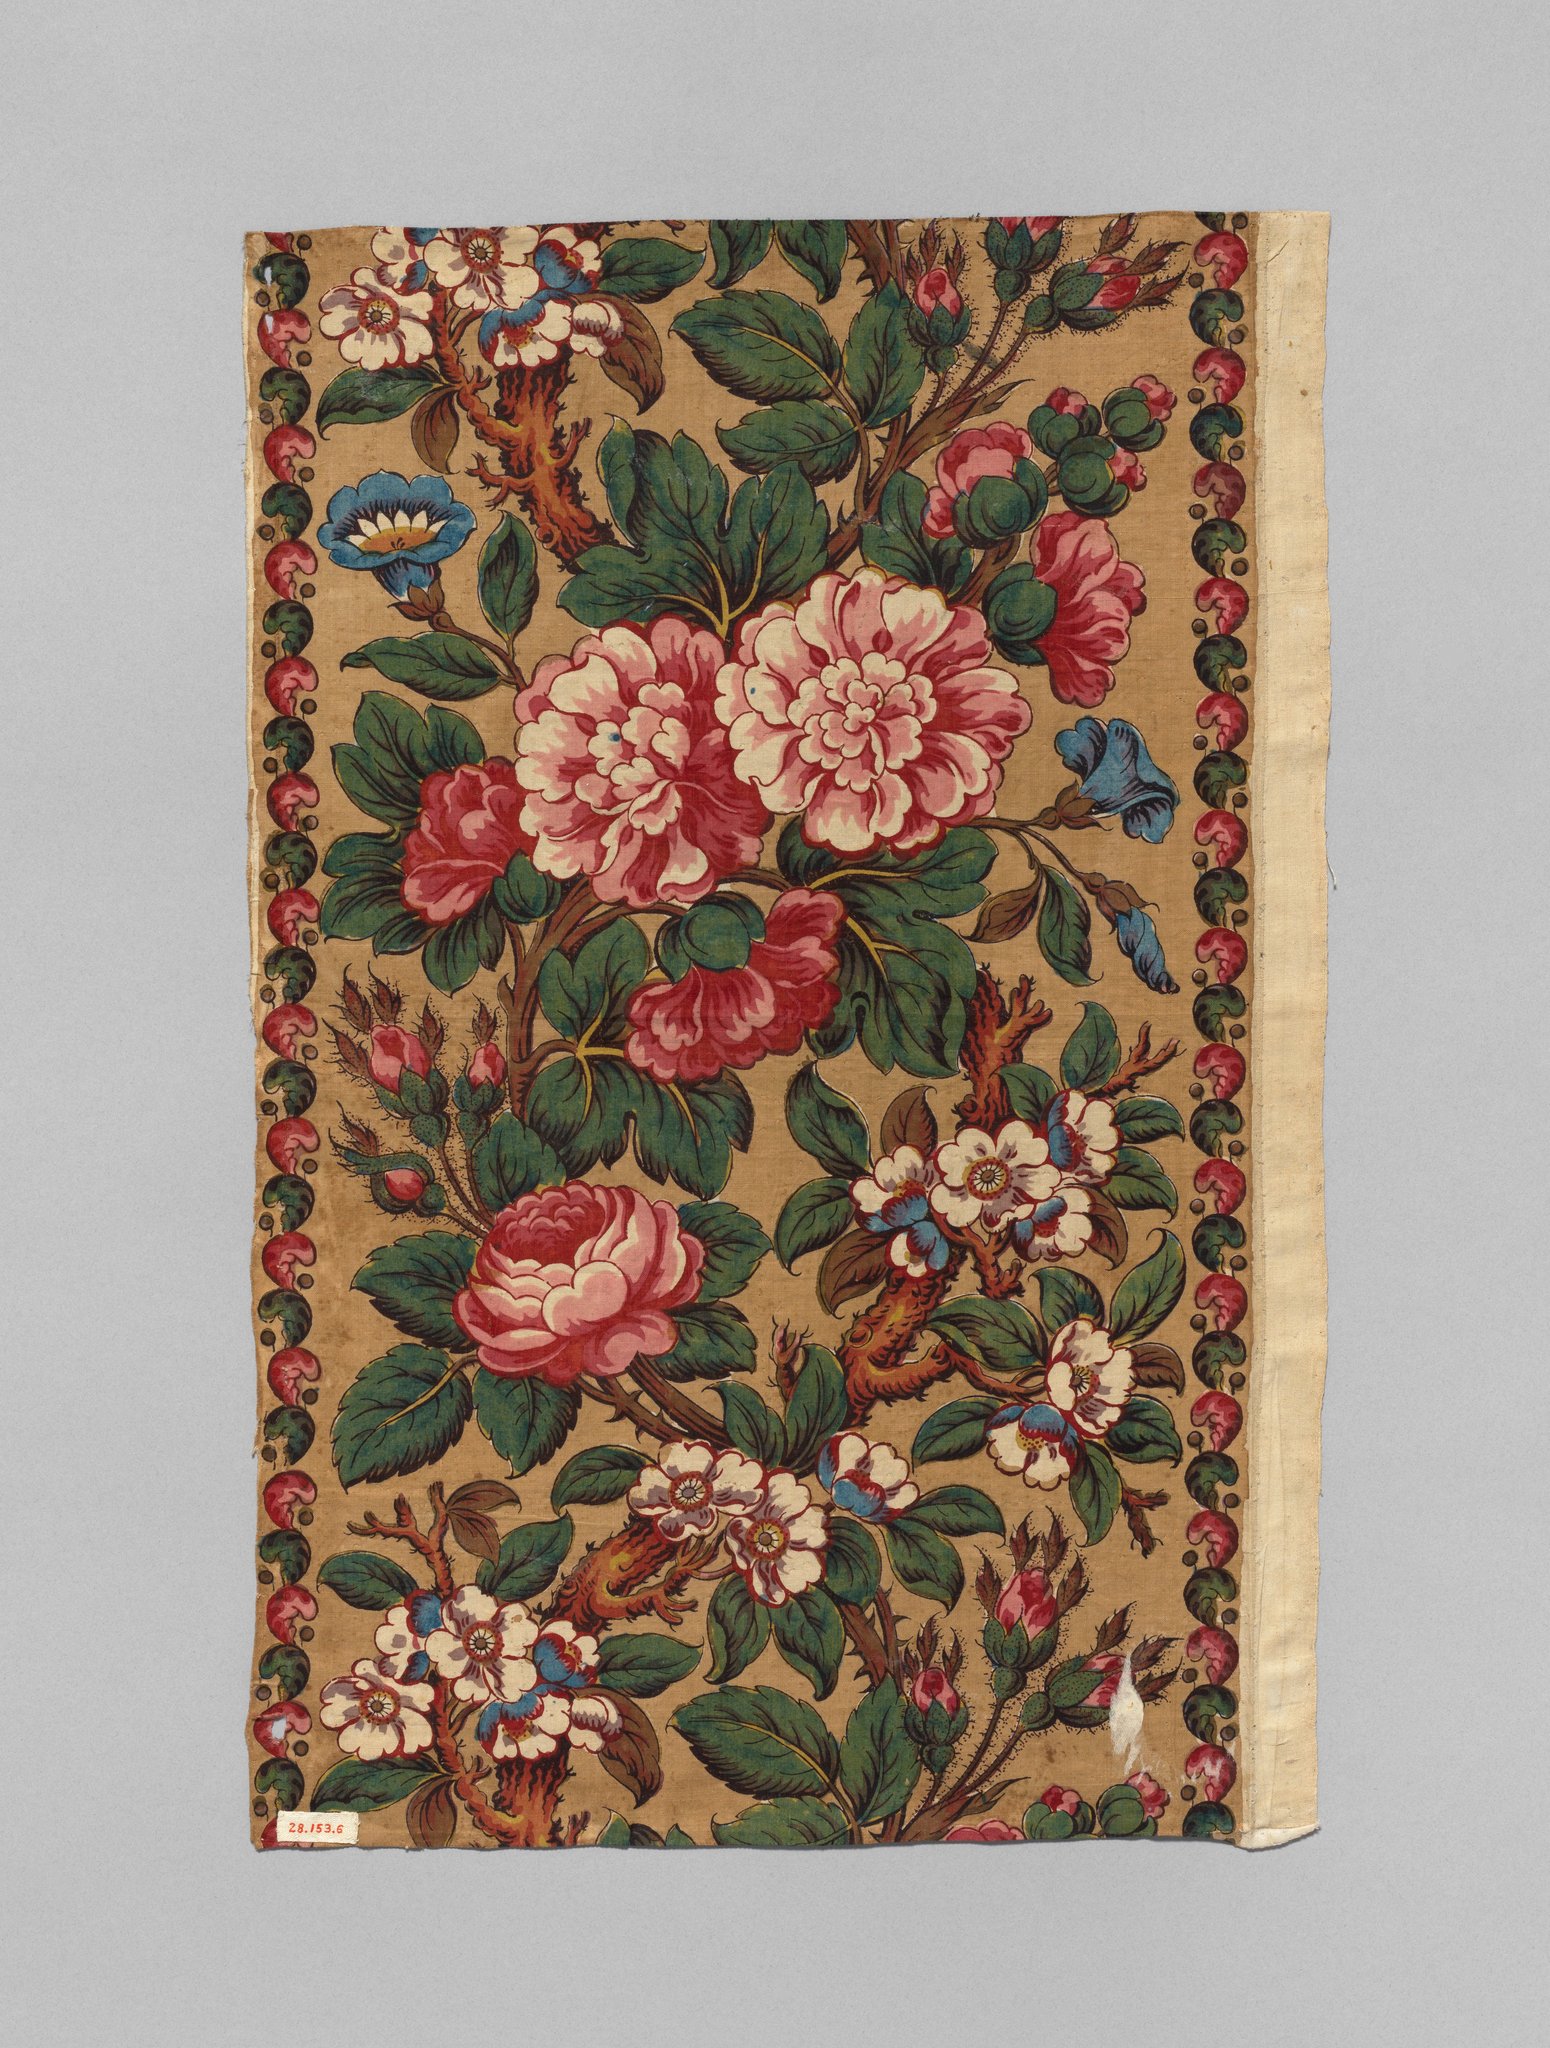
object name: border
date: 1815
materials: cotton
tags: roses